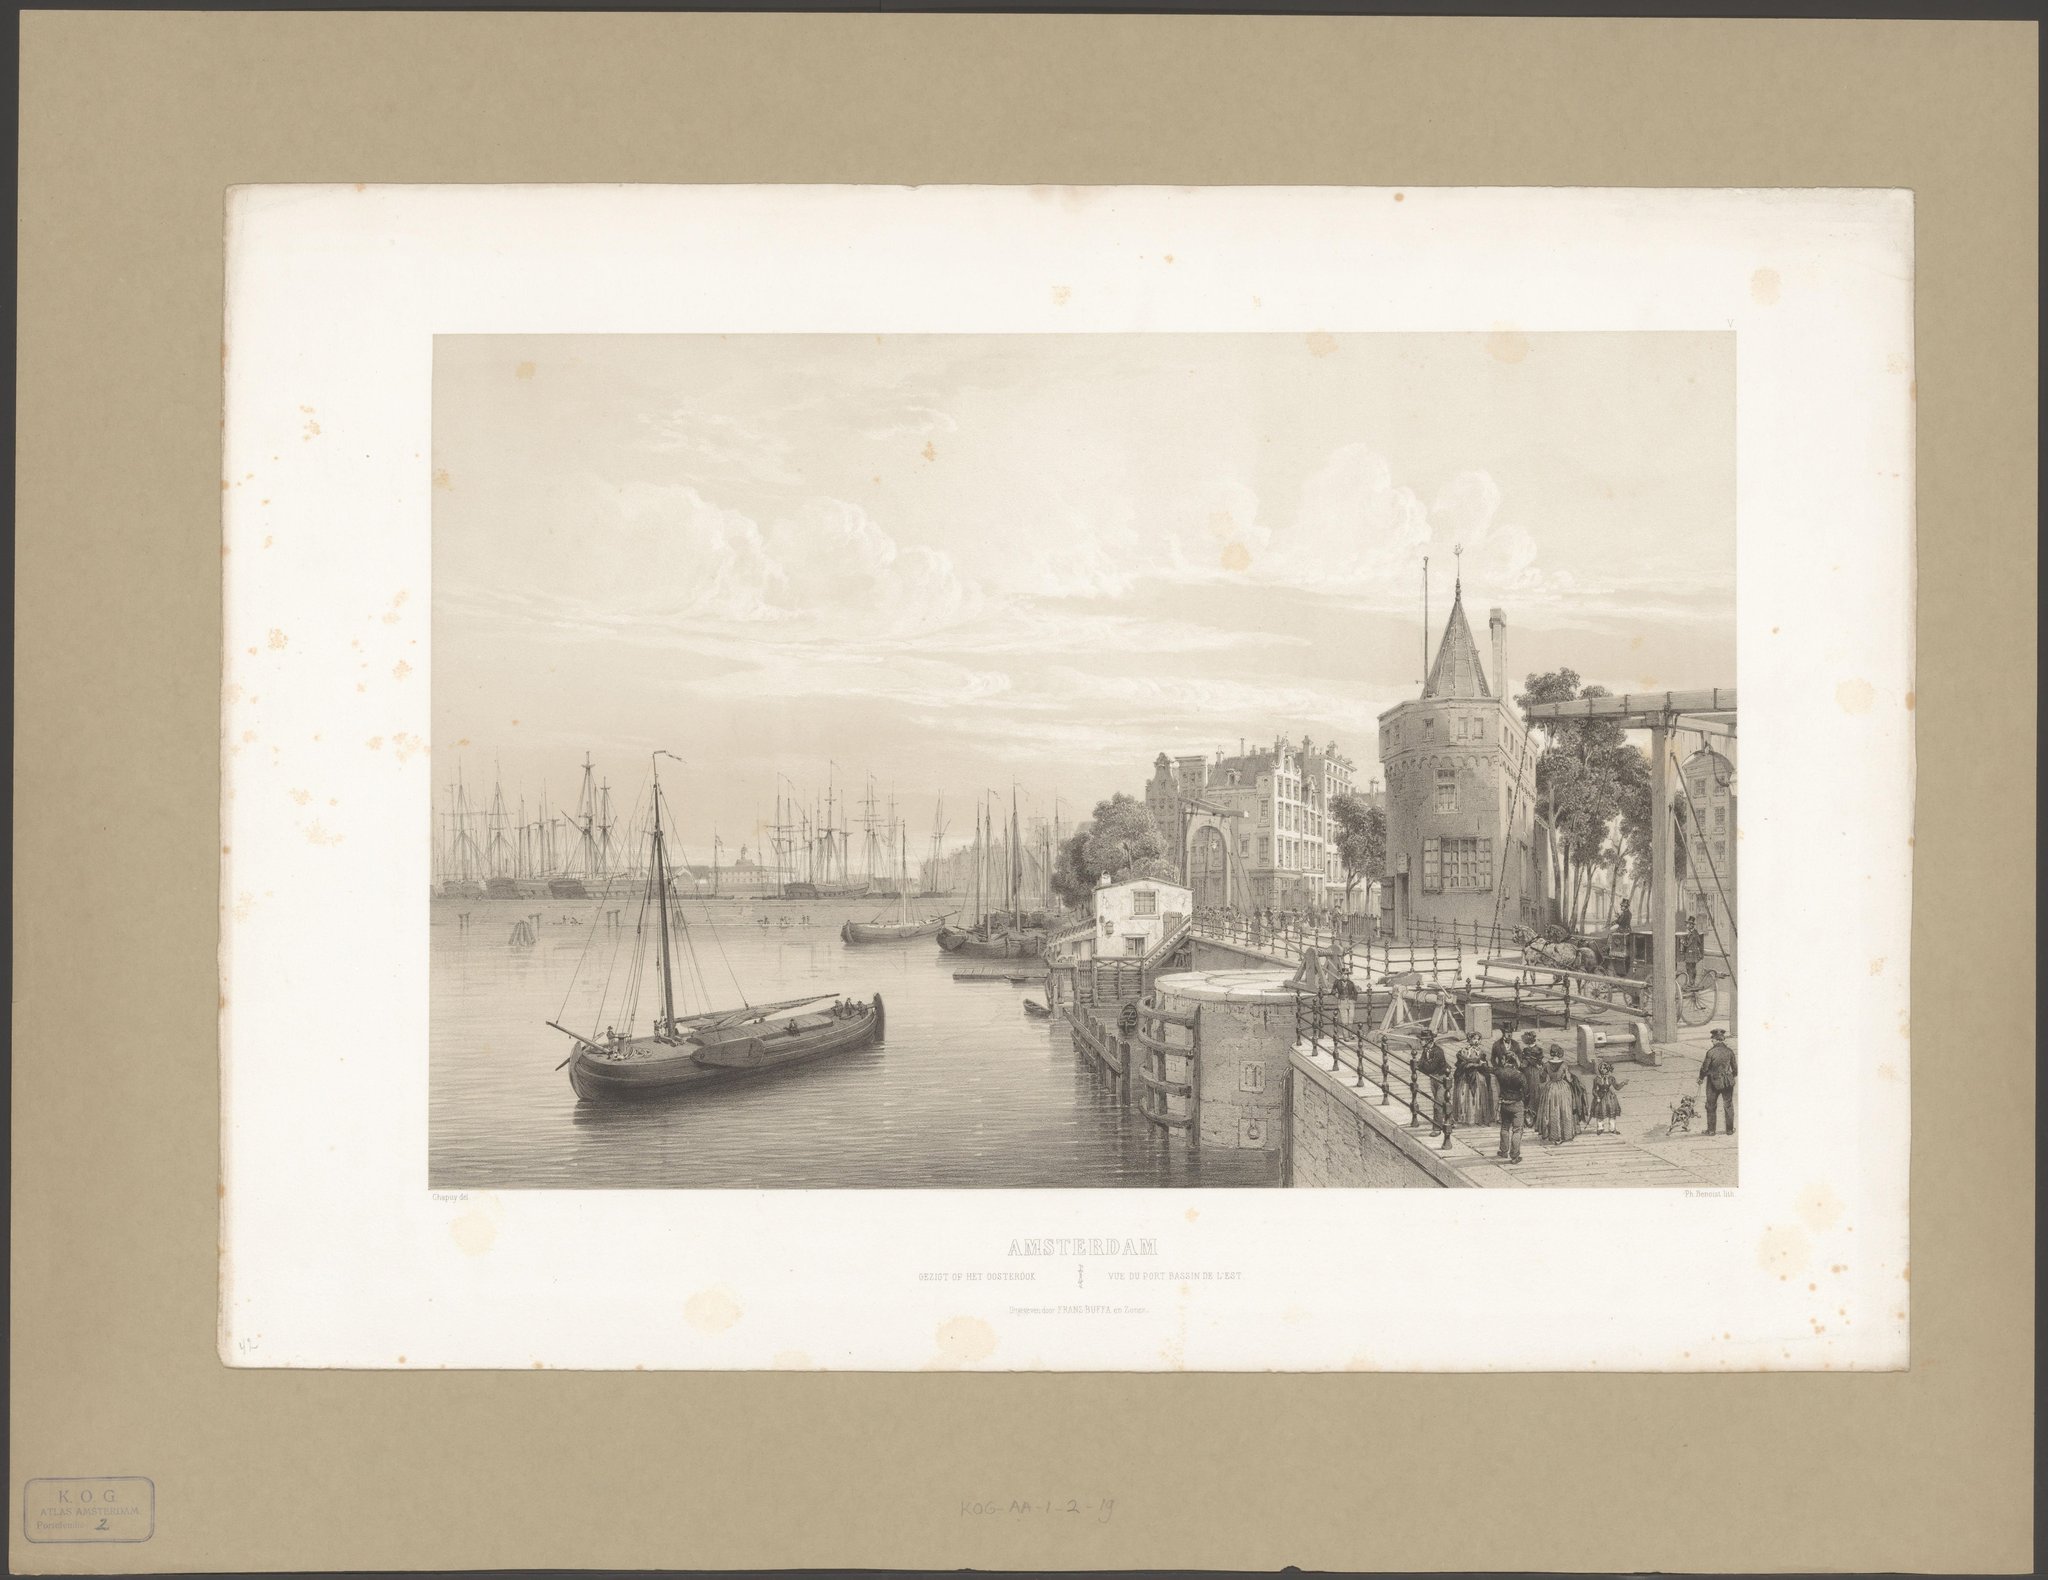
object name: print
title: Gezichten in Amsterdam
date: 1851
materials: paper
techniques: tone lithography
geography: amsterdam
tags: tower, clock tower ~ monumental adornment, city-view in general; 'veduta', river, ships (in general) - cc - more than one ship, bridge in city across river, canal, etc.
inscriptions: collector's mark: ‘2’ Lugt 1641b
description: Onderwerpsrubriek binnen de Atlas Amsterdam: Gezichten van het IJ op het Oostelijk gedeelte der stad, Nieuwebrug tot Zeeburg.